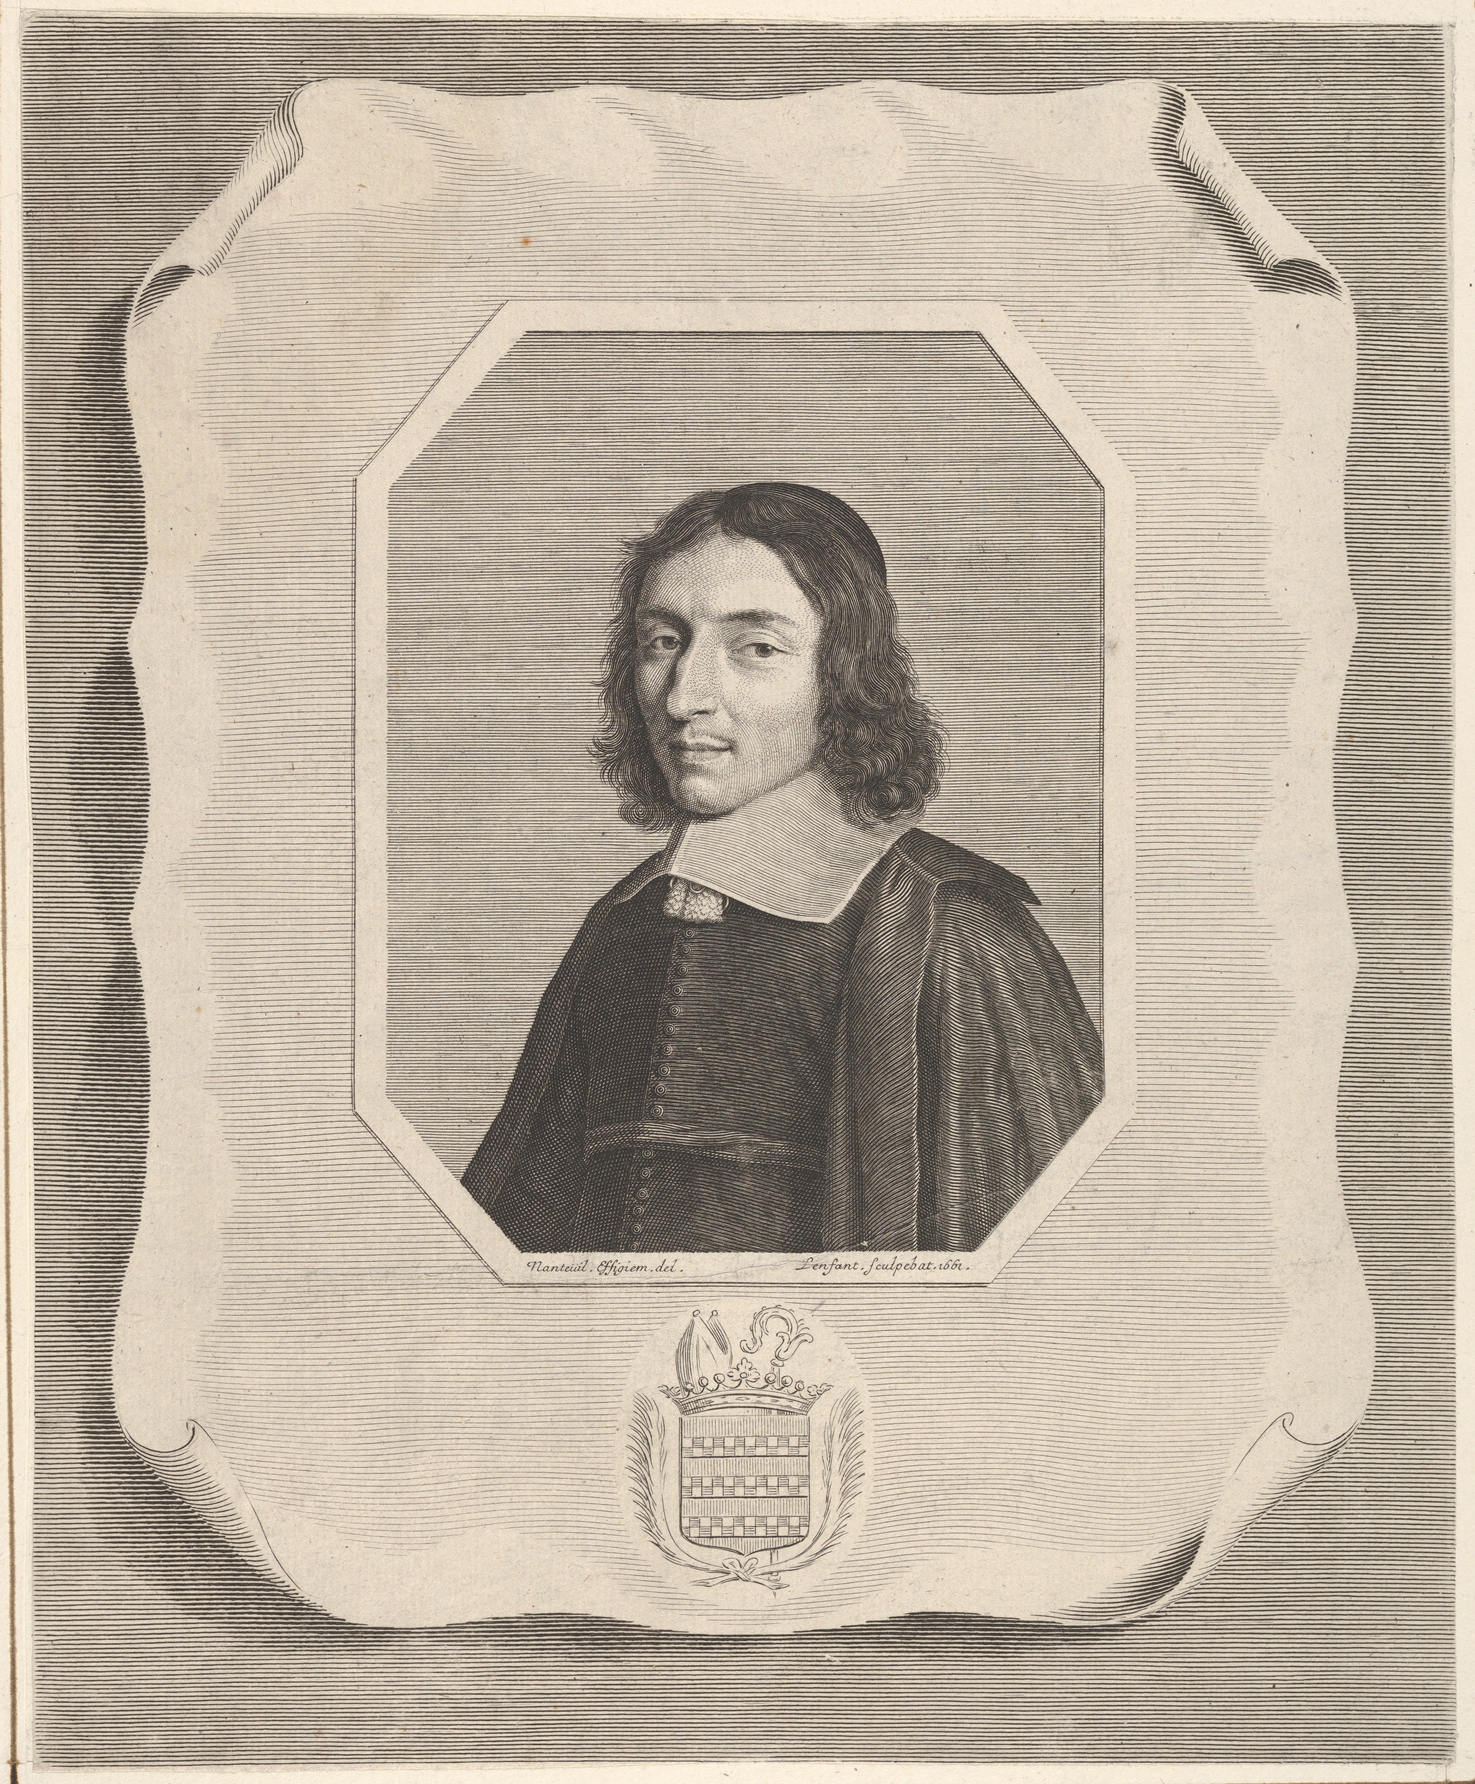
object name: print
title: Le cardinal de Coislin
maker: jean lenfant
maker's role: artist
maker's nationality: french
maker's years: 1615-1674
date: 1661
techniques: engraving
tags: men,portraits,coat of arms